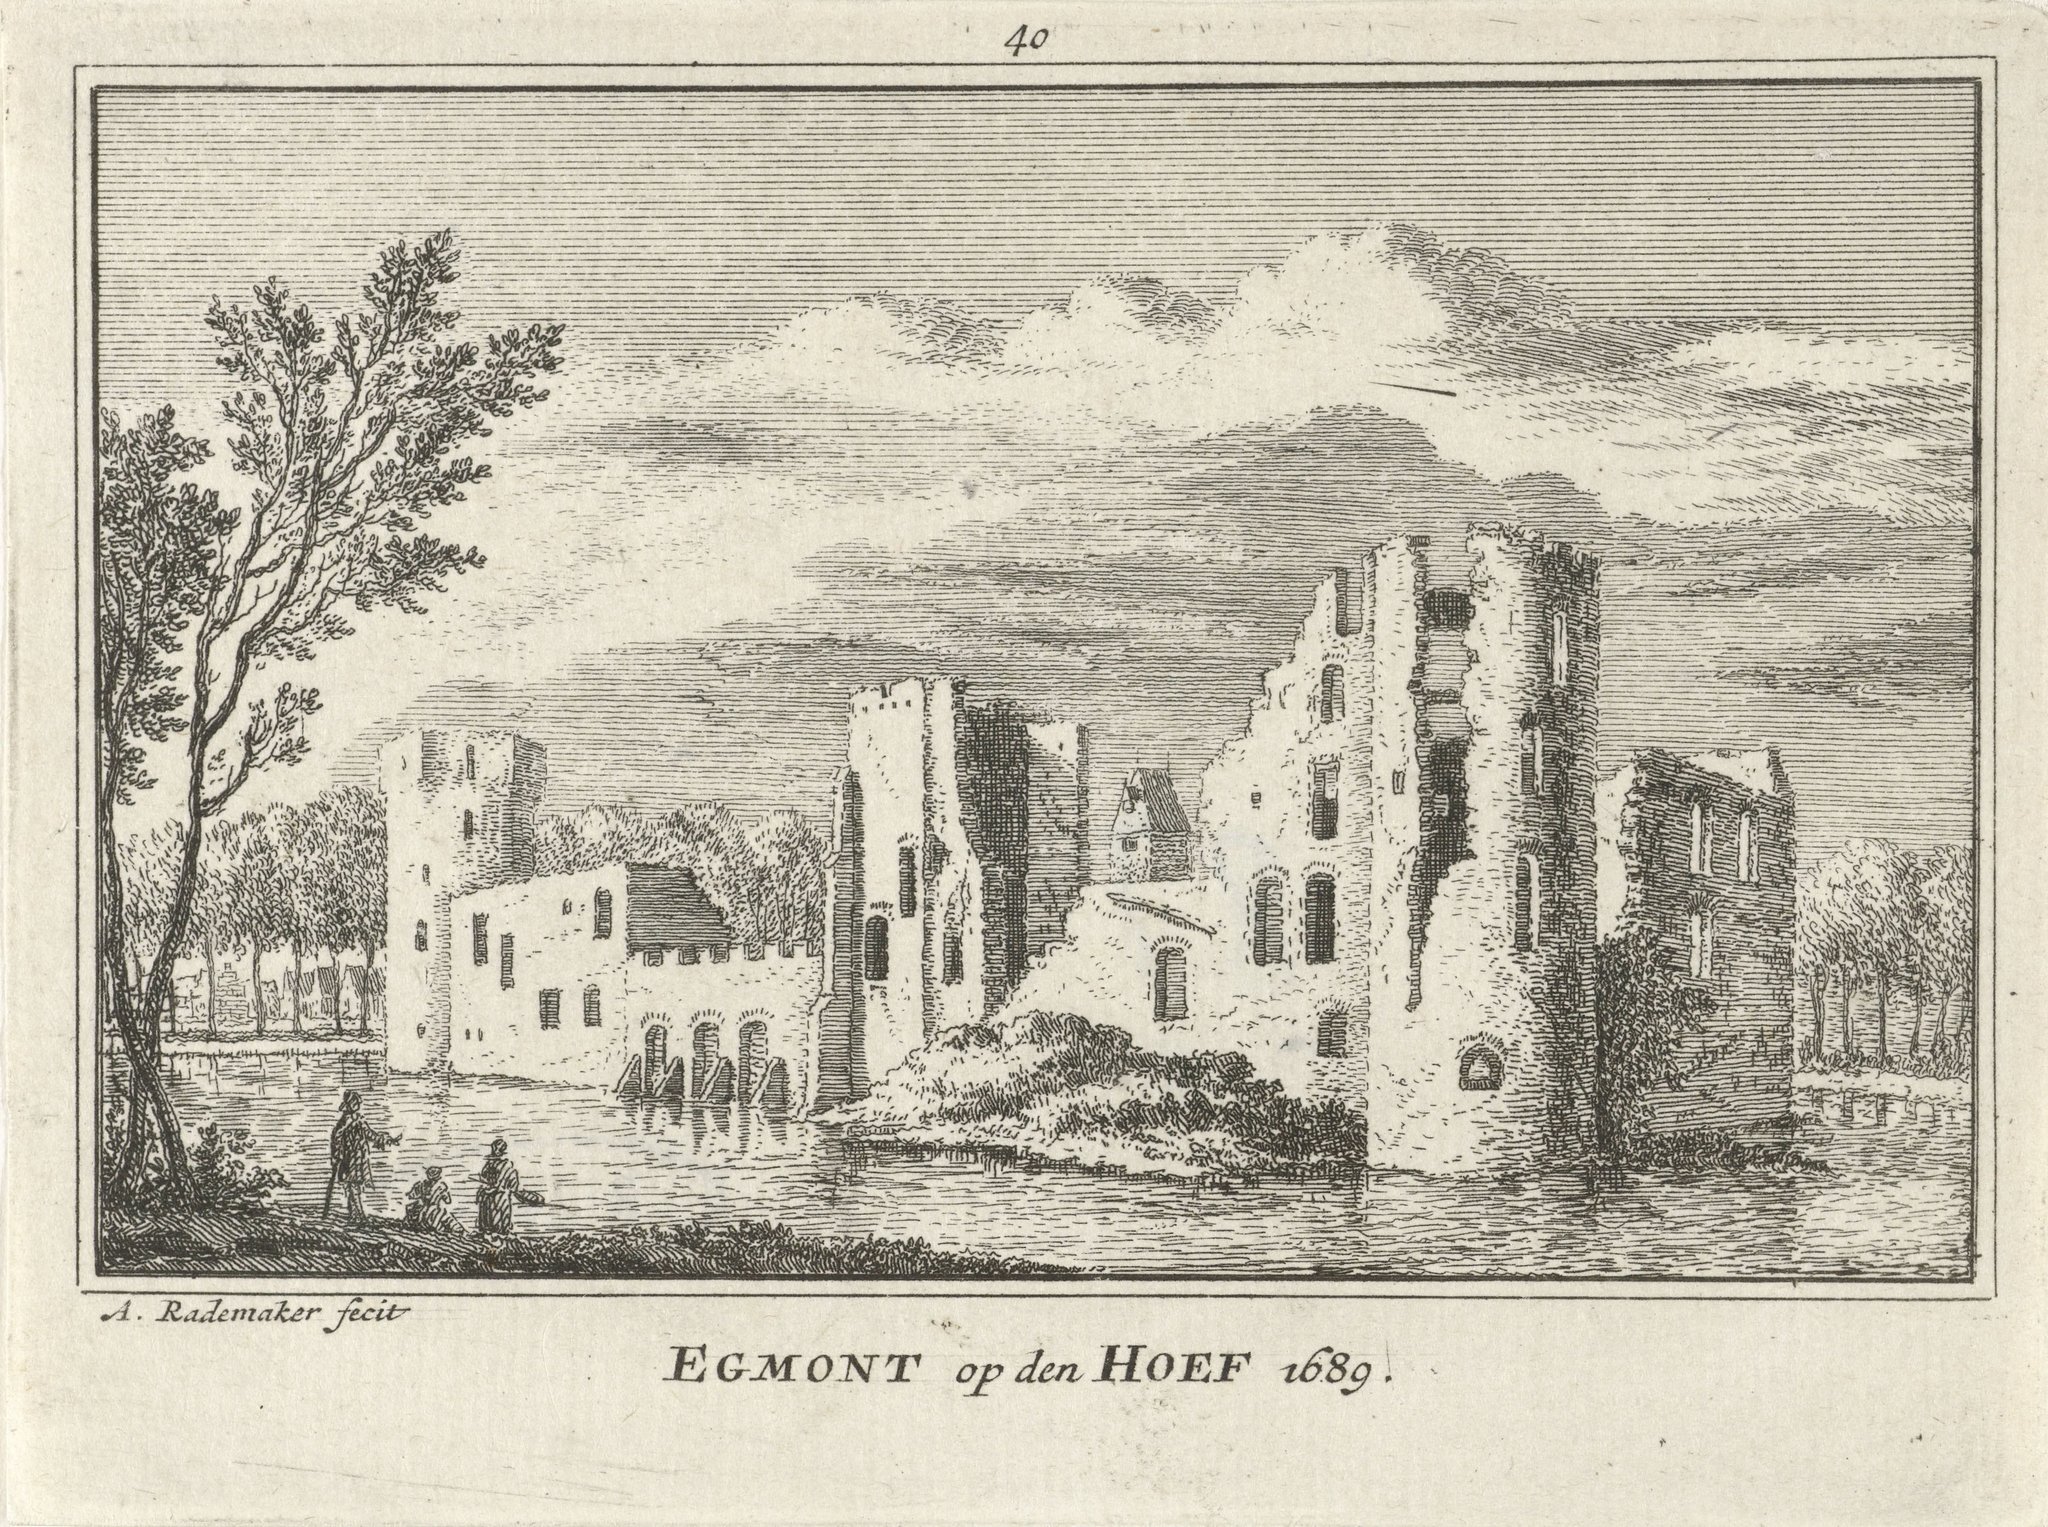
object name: book illustration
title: Egmont op den Hoef 1689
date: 1727-1733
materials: paper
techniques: etching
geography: amsterdam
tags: castle, ruin of a dwelling, house, castle, etc.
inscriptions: collector's mark: Lugt 2228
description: Illustratie uit: Abraham Rademaker, Matthaeus Brouërius van Niedek, Isaac Le Long, Kabinet van Nederlandsche en Kleefsche outheden en (...) voorname stads- en landgebouwen, Willem Barents en Antoni Schoonenburg: Amsterdam, 1727-1733, ill. nr. 40.